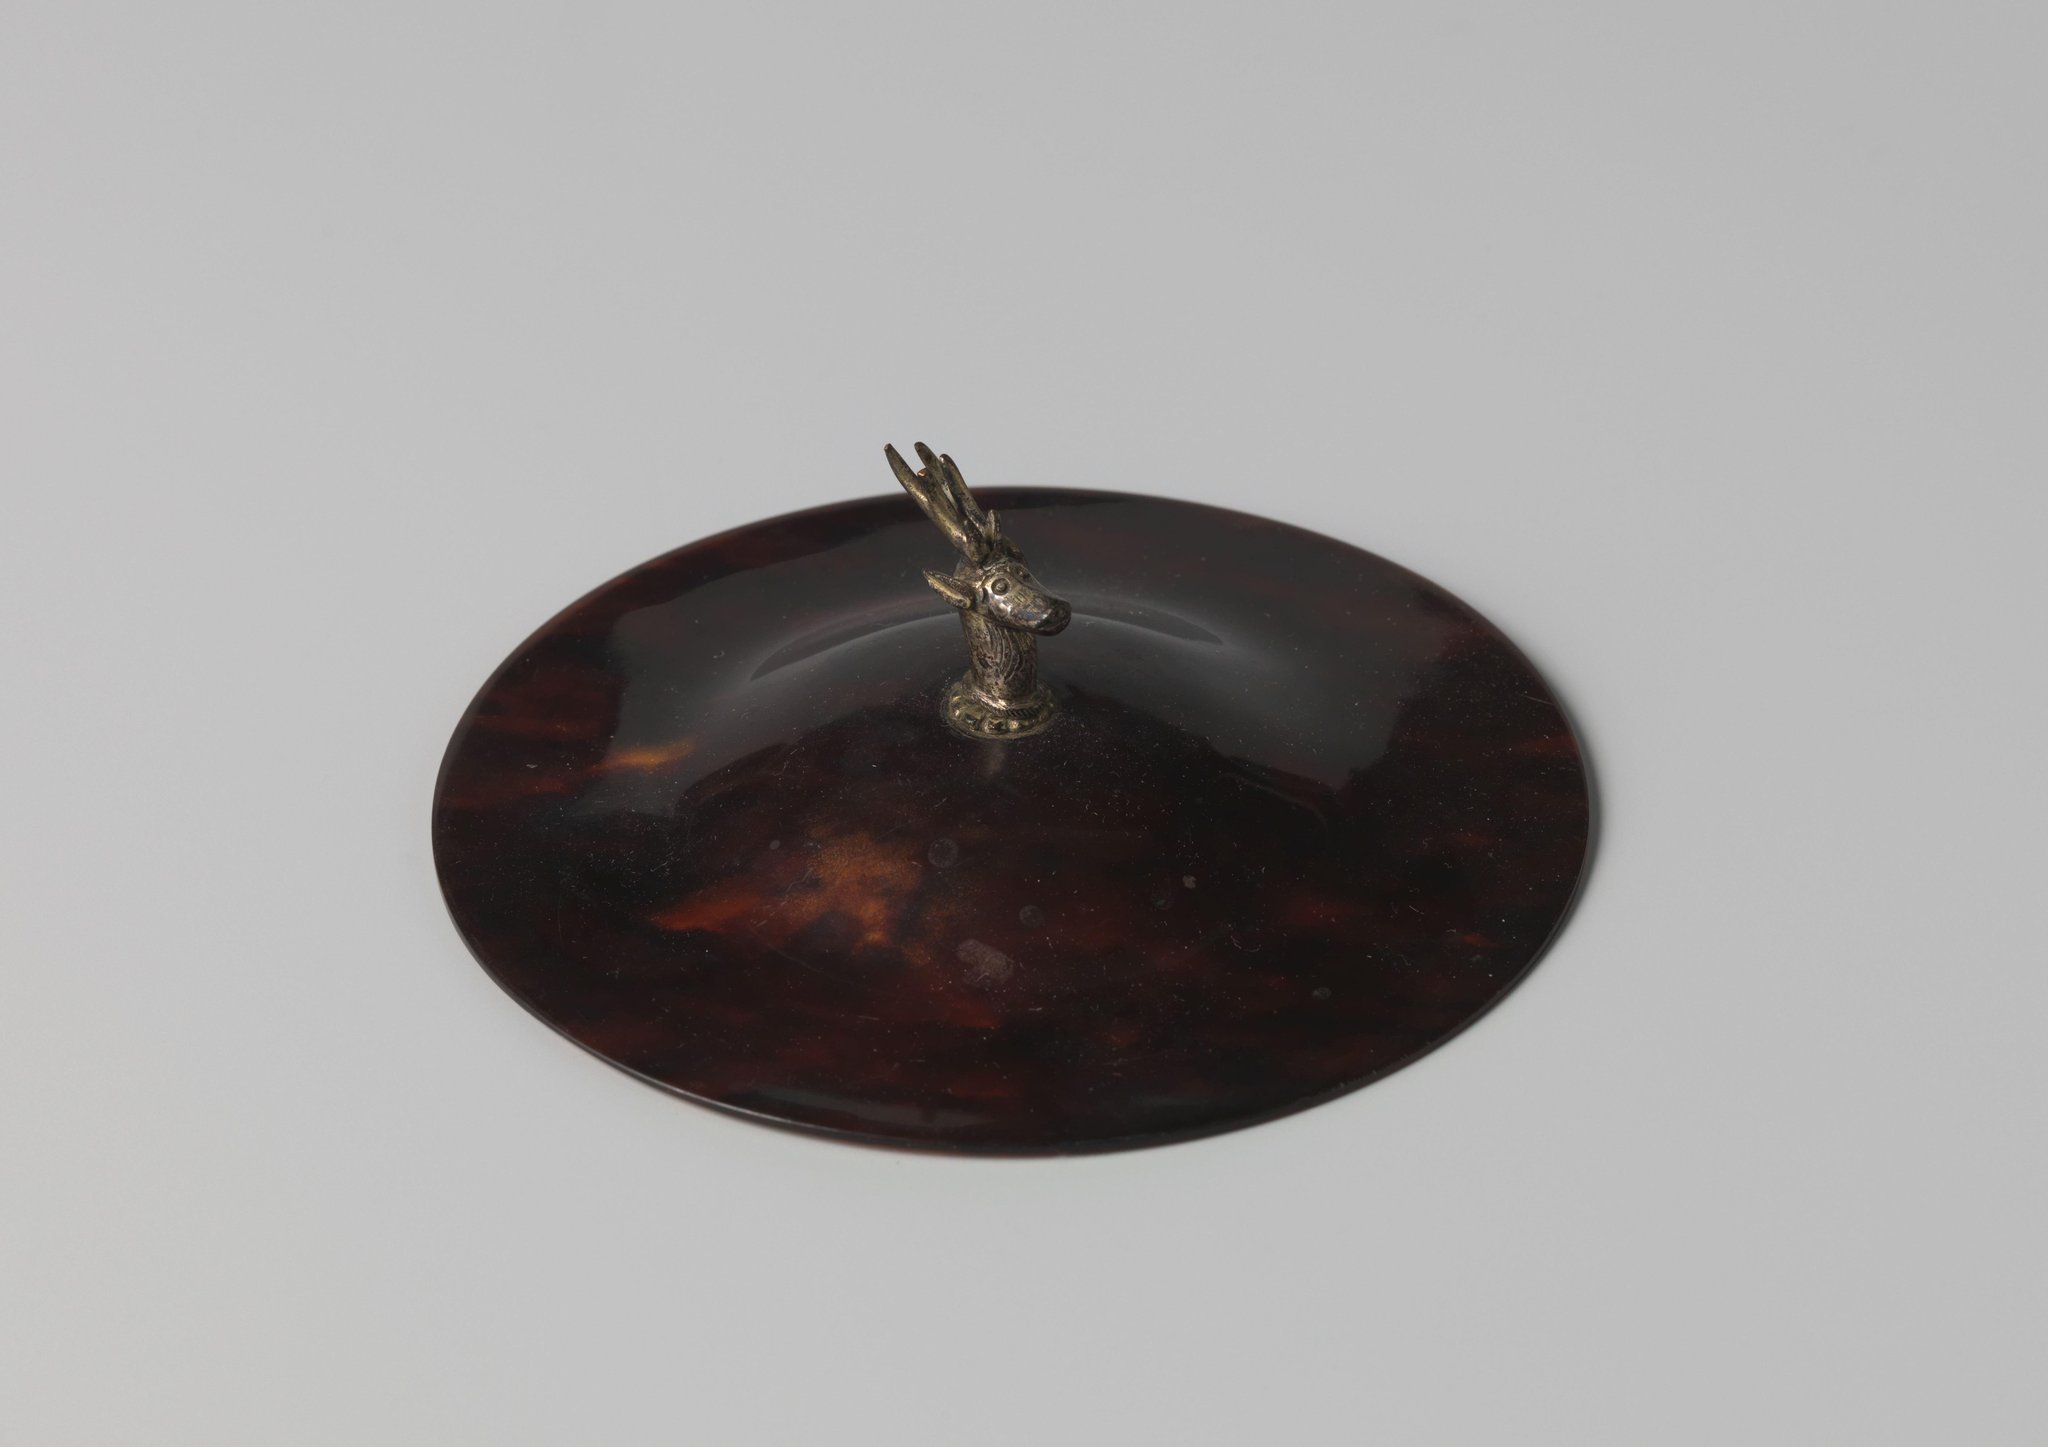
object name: lid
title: Deksel van schildpad met hertekop van zilver (serie van 28 stuks A t/m BB)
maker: Anonymous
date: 1700-1799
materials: silver, shell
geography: indonesia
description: Schildpad-deksel (28 stuks: A t/m BB) met hertekop van zilver als knop.